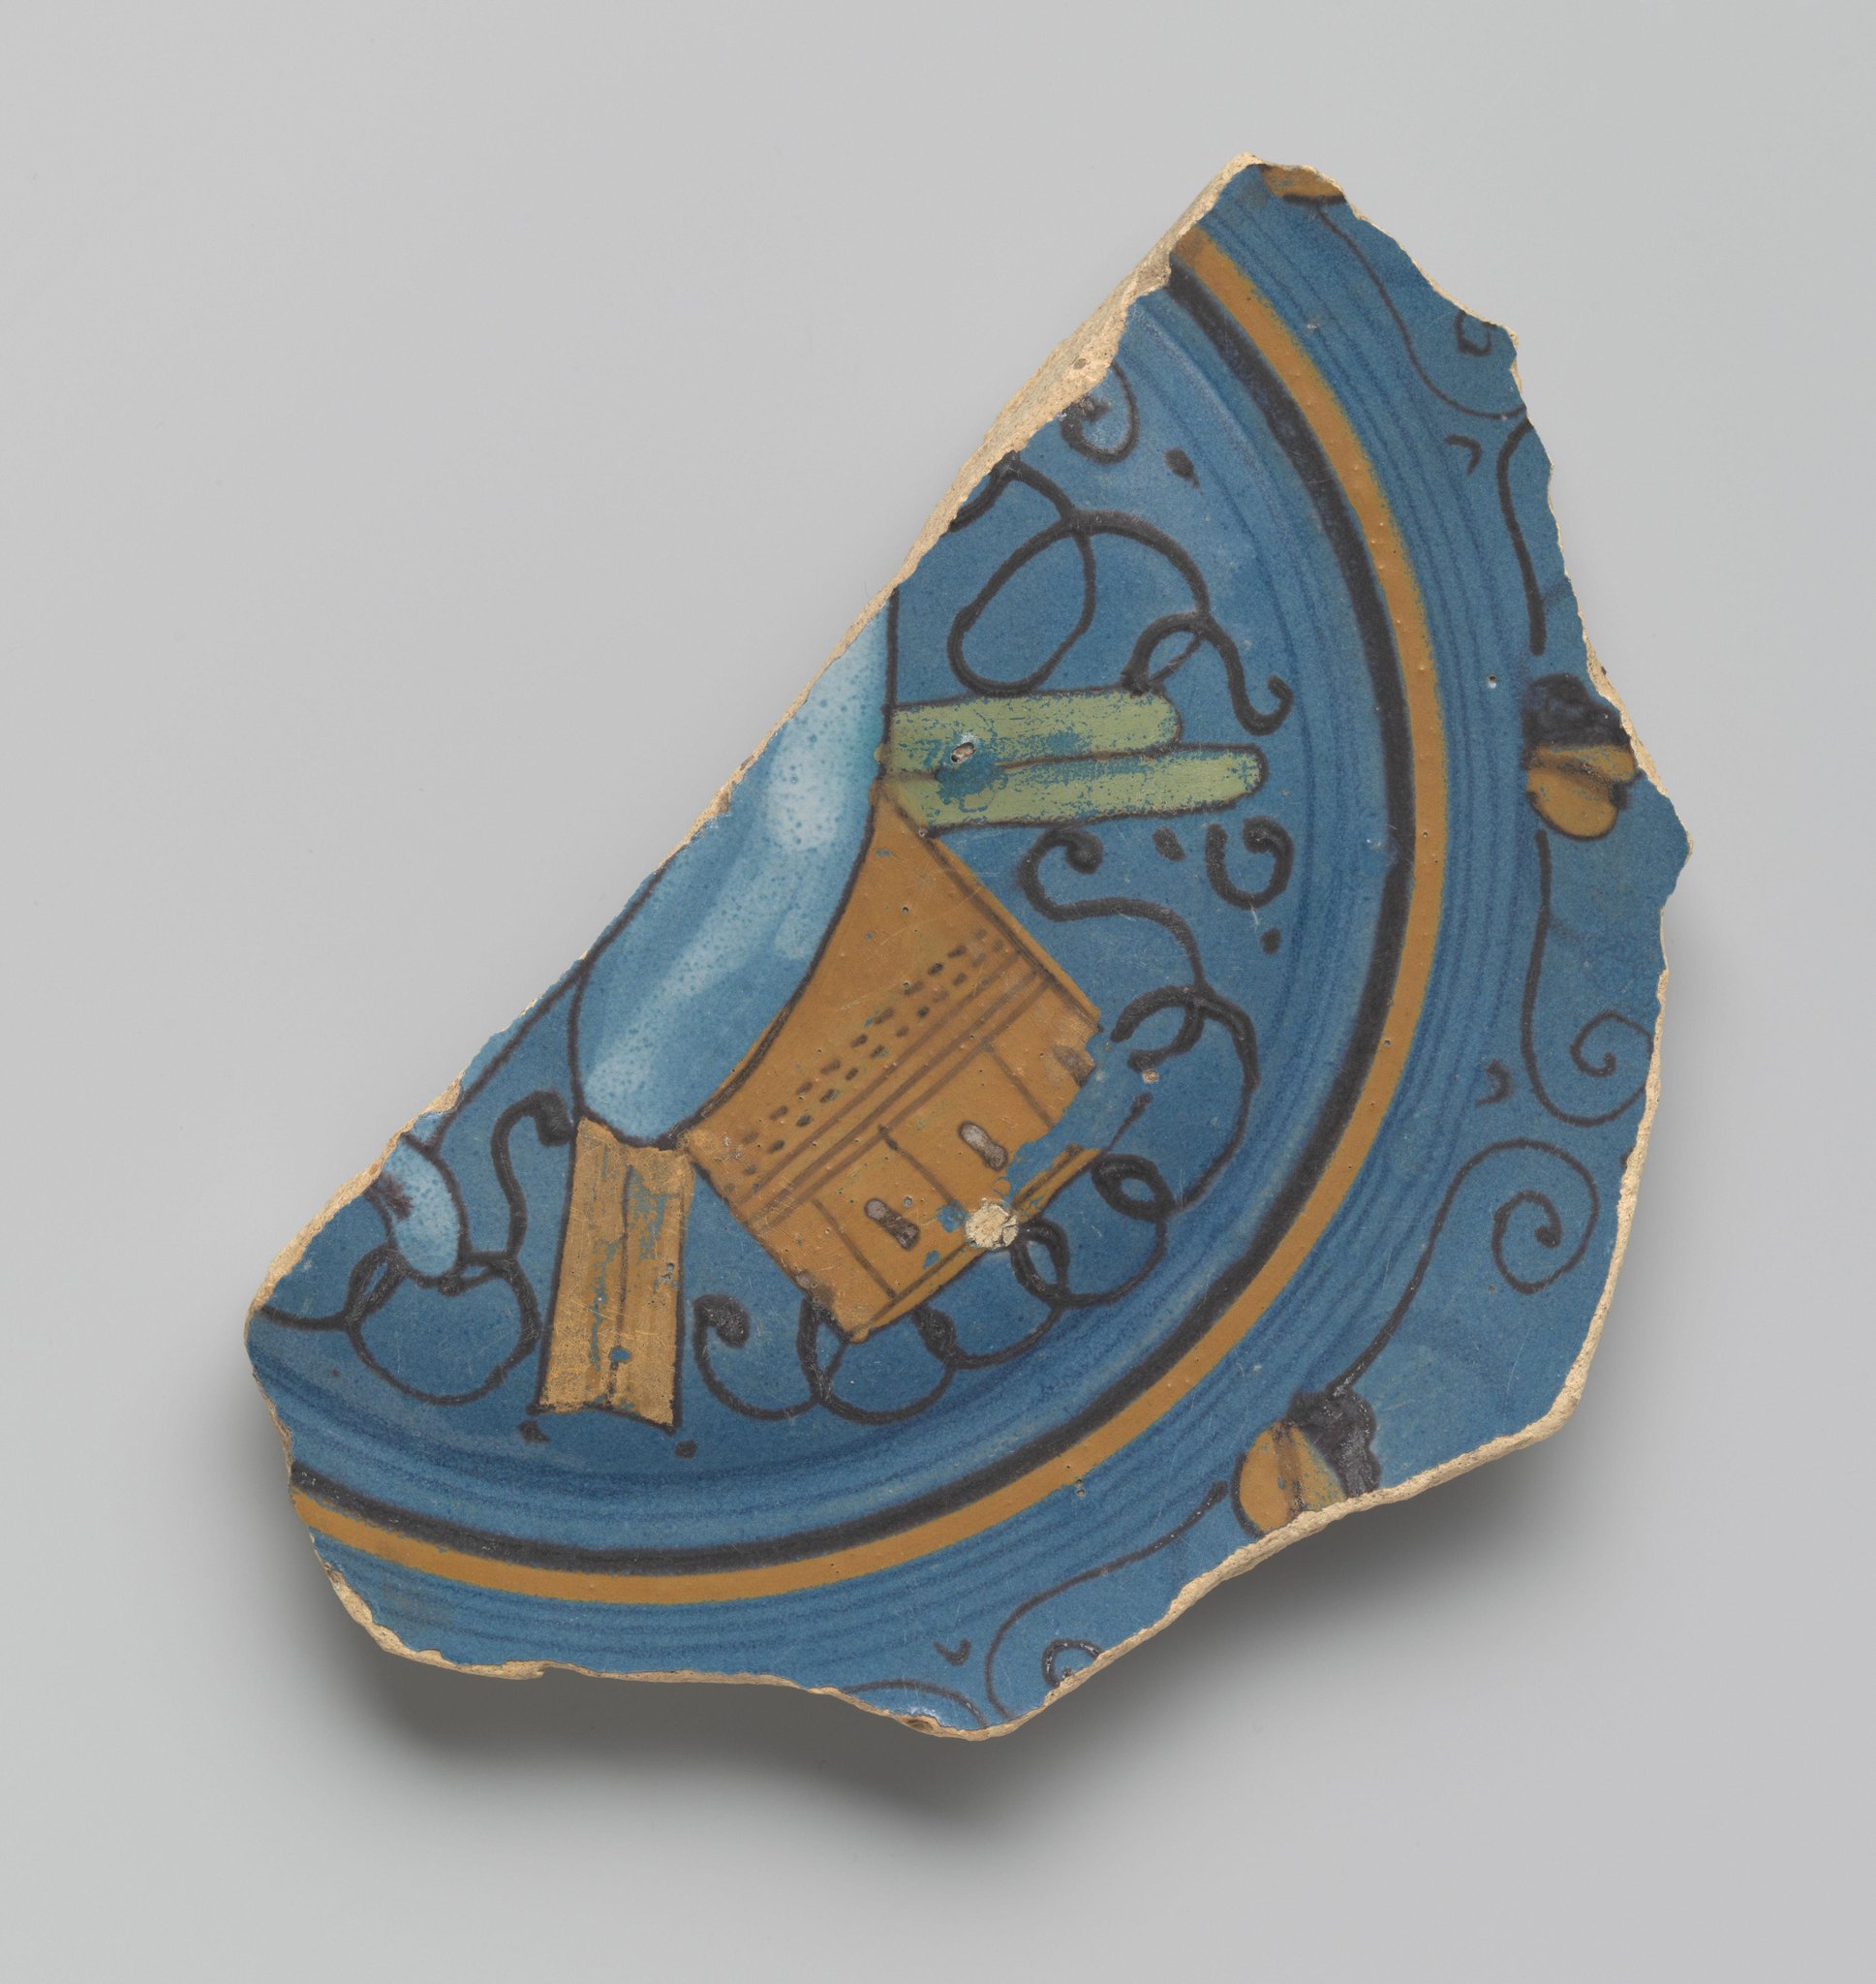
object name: sherd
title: Een collectie scherven opgegraven in de leeuwekooien van Artis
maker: Anonymous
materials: earthenware, glaze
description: Een collectie scherven opgegraven in de leeuwekooien van Artis, bestaande uit: 6 kannen van bruin aardewerk (allemaal flink beschadigd). 3 potjes van bruin aardewerk. 1 voet van een pot van bruin aardewerk. 2 bruine potten met loodglazuur. 1 bruine kan met loodglazuur. 1 beschadigde Westerwaldsche kan. 1 schotelscherf. 14 schotelscherven met diverse voorstellingen. 5 schotelscherven. 1 schotelscherf met tinglazuur. 1 schotelscherf met haan. 14 schotelscherven met diverse ornamenten. 1 schotelscherf. Een kinderkopje van zandsteen.